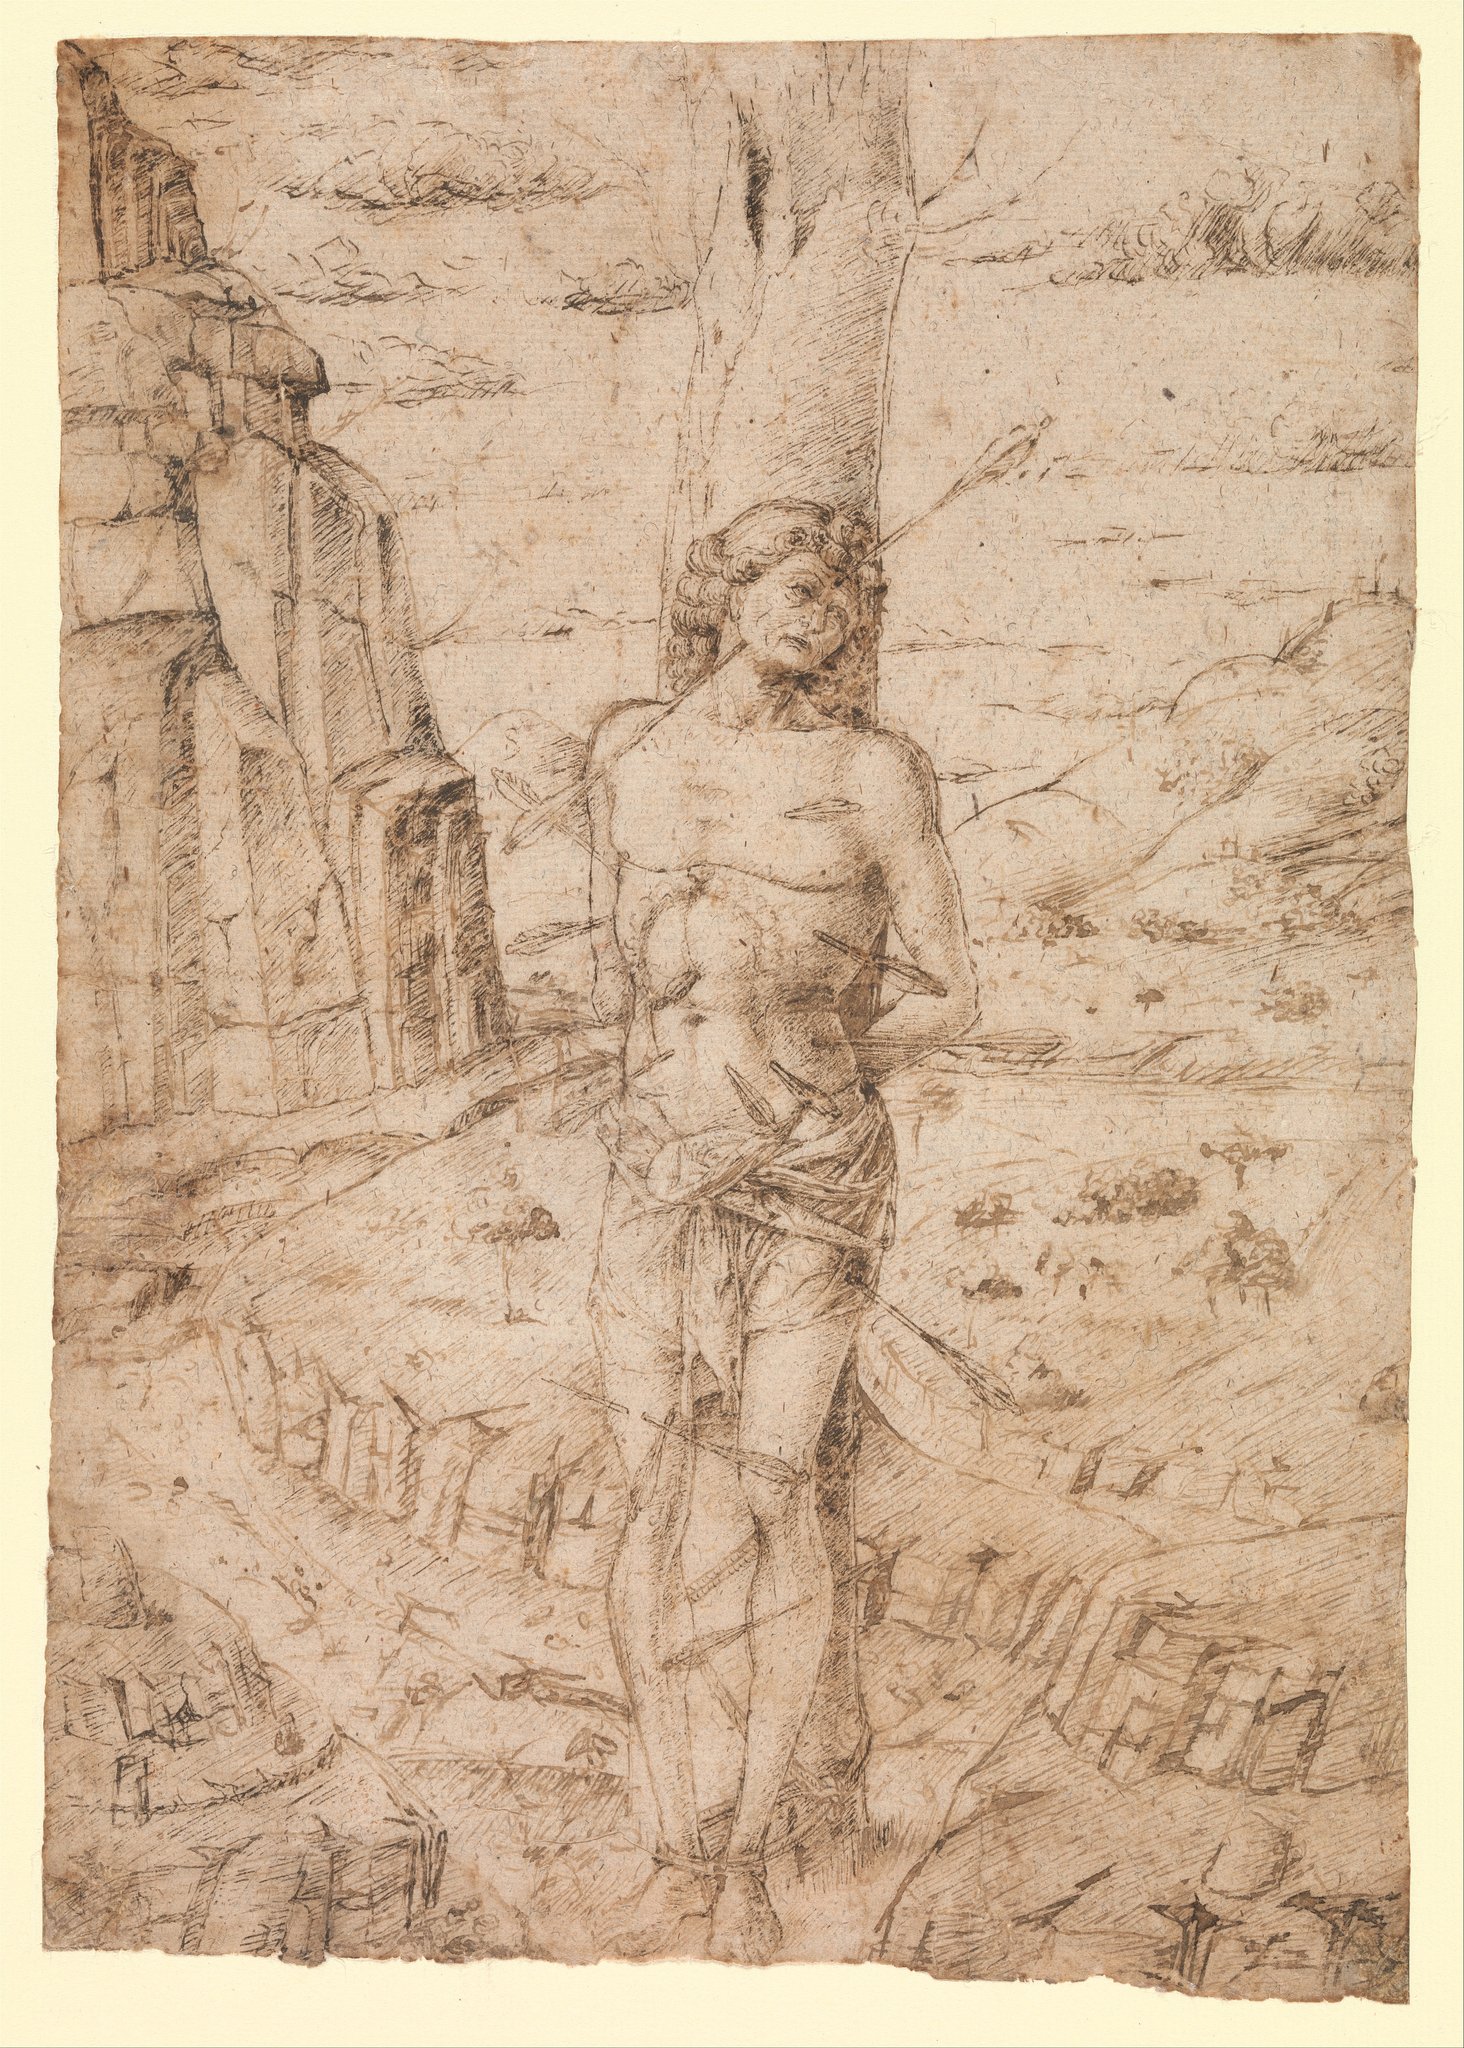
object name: drawing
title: Saint Sebastian in a Landscape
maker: ferrara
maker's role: artist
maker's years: 1470-1499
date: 1467-1500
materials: ink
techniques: pen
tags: men,saint sebastian